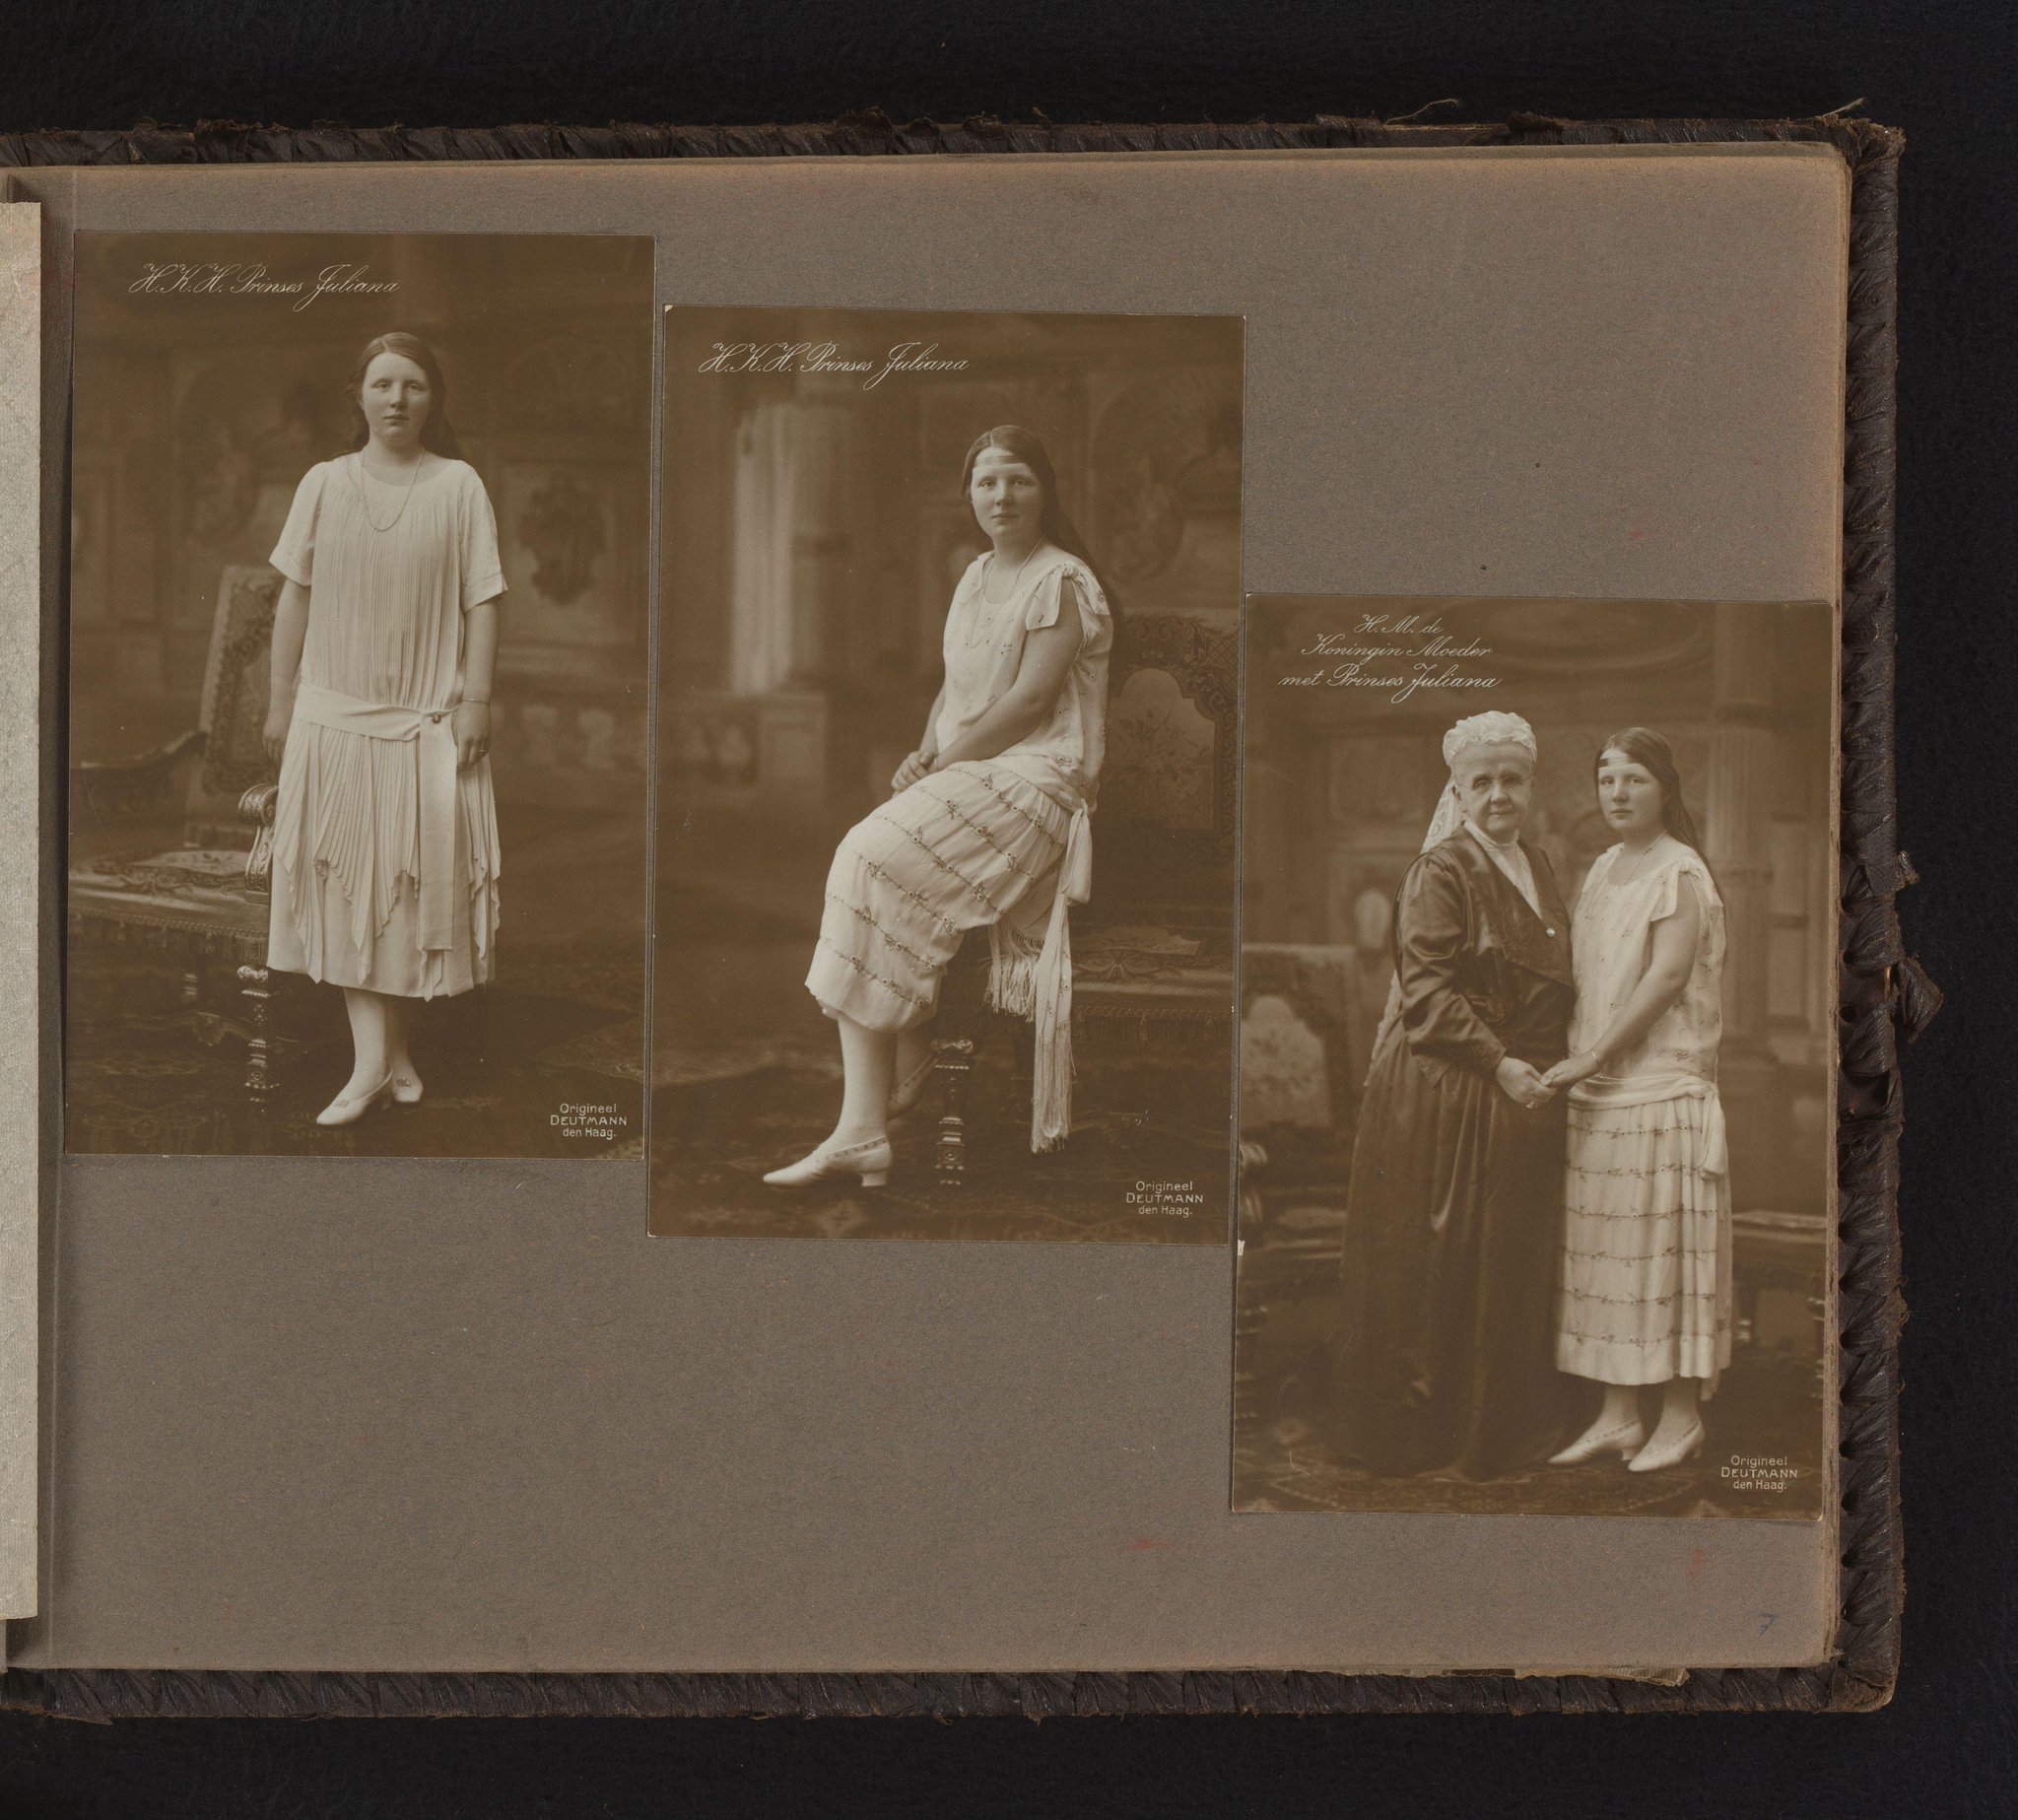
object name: photograph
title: Drie portretten van prinses Juliana op zestienjarige leeftijd, ook samen met koningin-moeder Emma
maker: herman deutmann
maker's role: fotograaf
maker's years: 1870-1926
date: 1925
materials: paper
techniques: gelatin silver print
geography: the hague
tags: emma (queen consort of the netherlands), juliana of the netherlands, adolescent, young woman, maiden, historical persons - bb - woman, old woman, the hague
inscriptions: inscription: ‘HKH Prinses Juliana/ Origineel/ Deutmann/ Den Haag.’, inscription: ‘HKH Prinses Juliana/ Origineel/ Deutmann/ Den Haag.’, inscription: ‘HM de/ Koningin Moeder/ met Prinses Juliana/ Origineel/ Deutmann/ Den Haag.’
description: Deze foto's maken deel uit van een album.